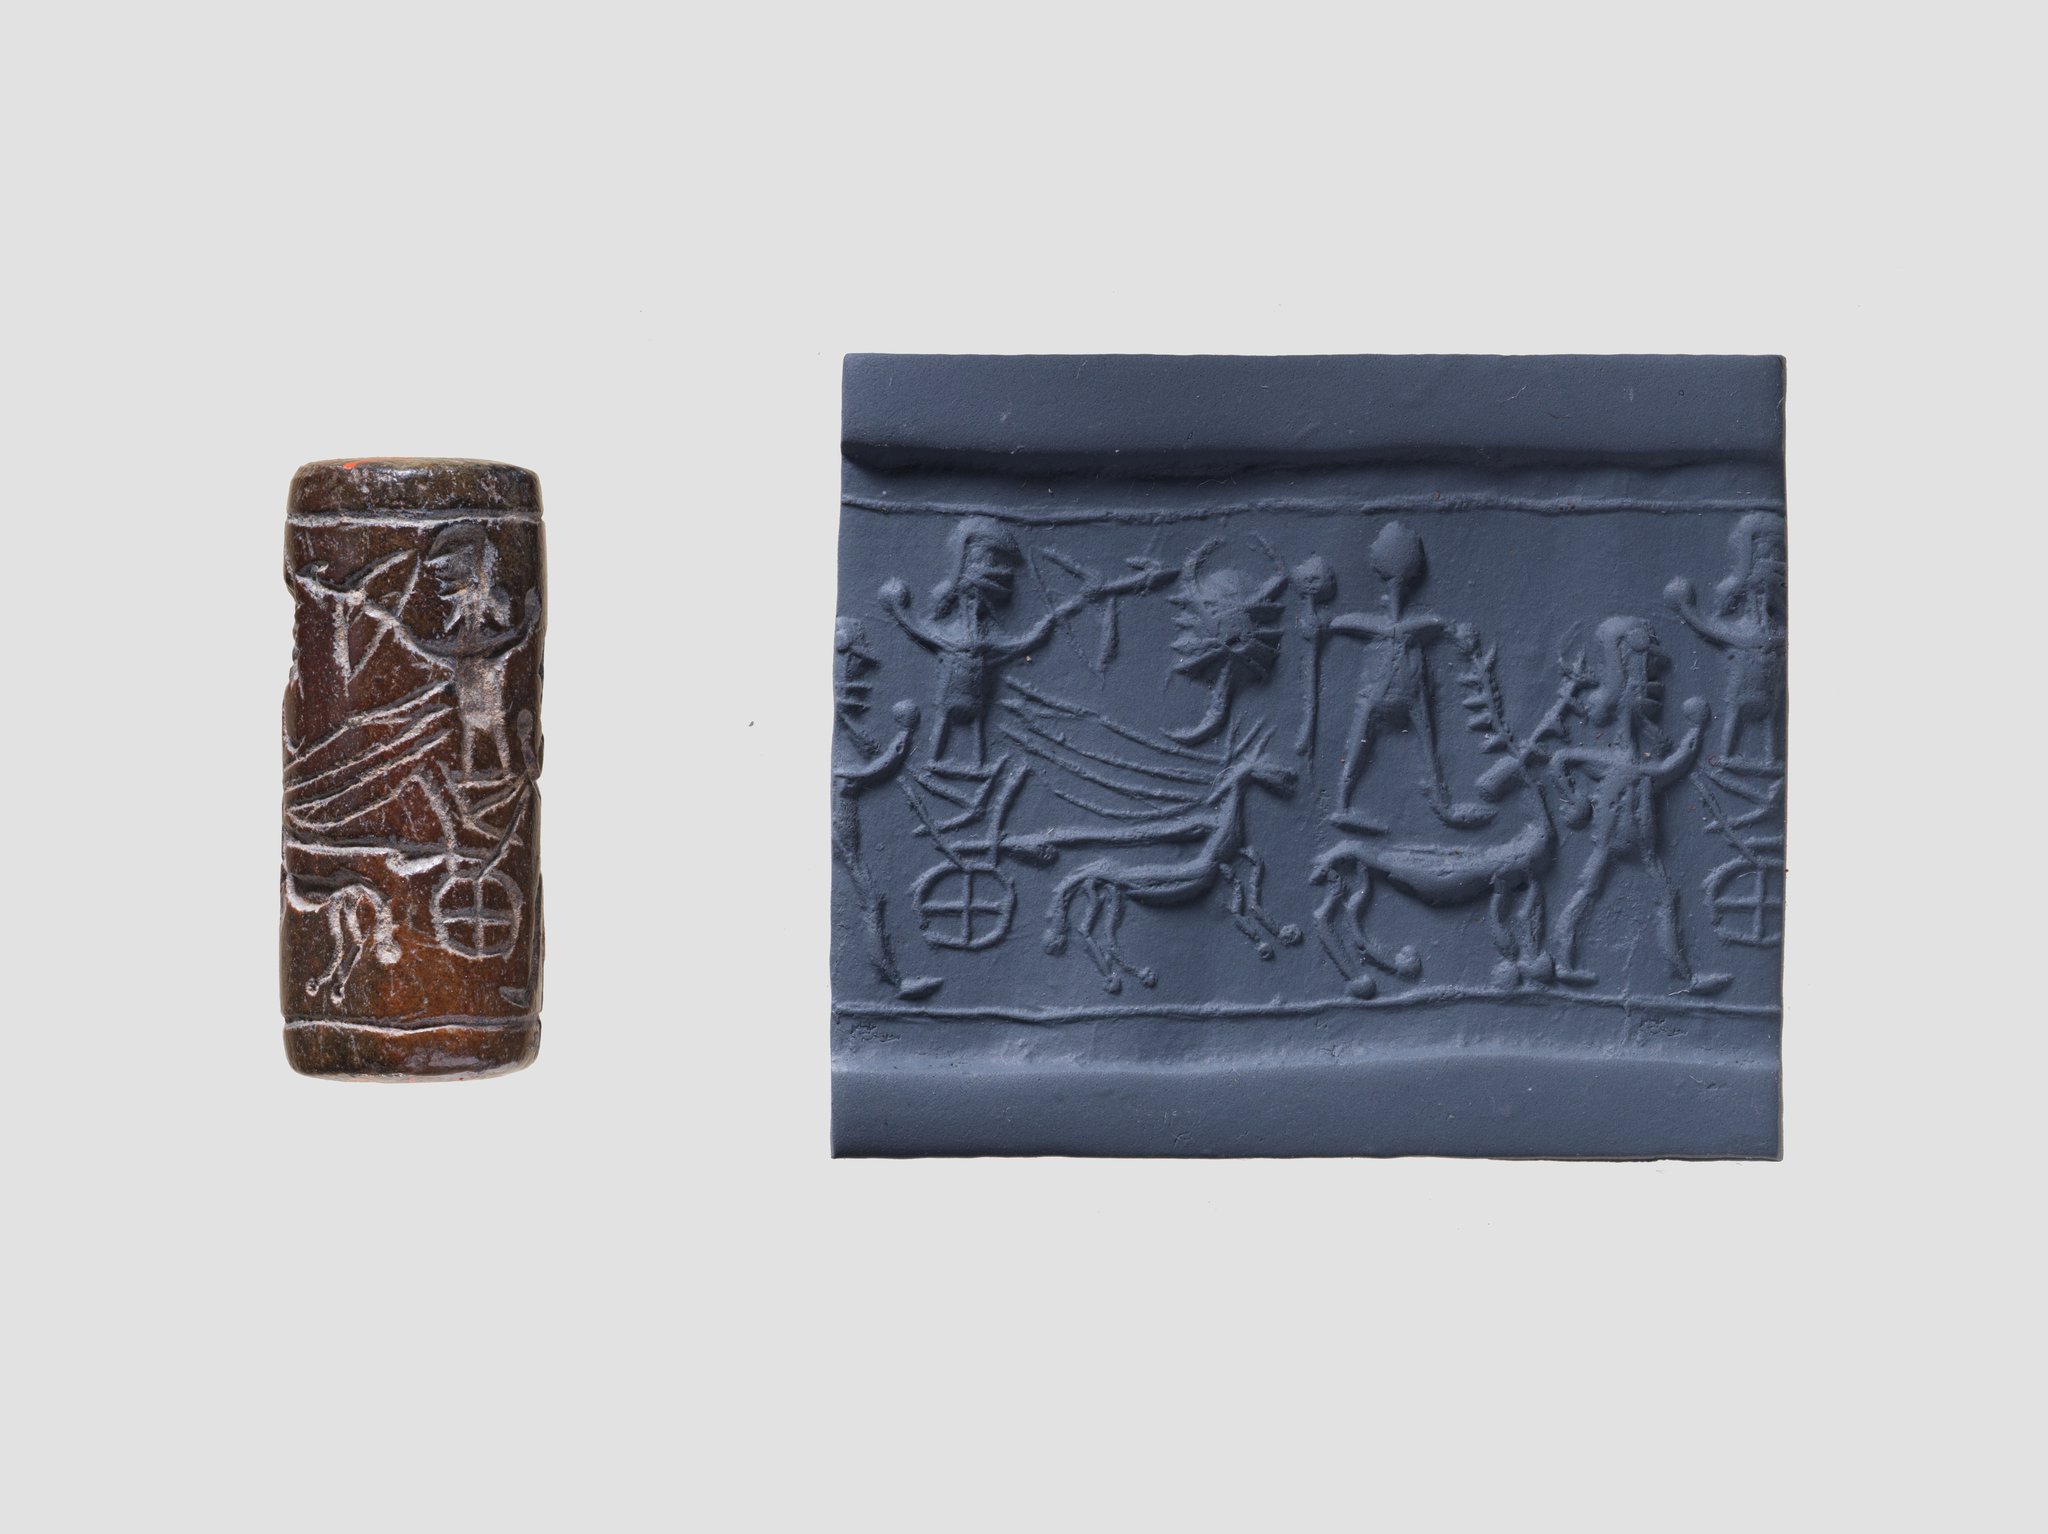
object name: cylinder seal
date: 1667-1001 BCE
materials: stone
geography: syria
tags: hunting,horses,scorpions,chariots